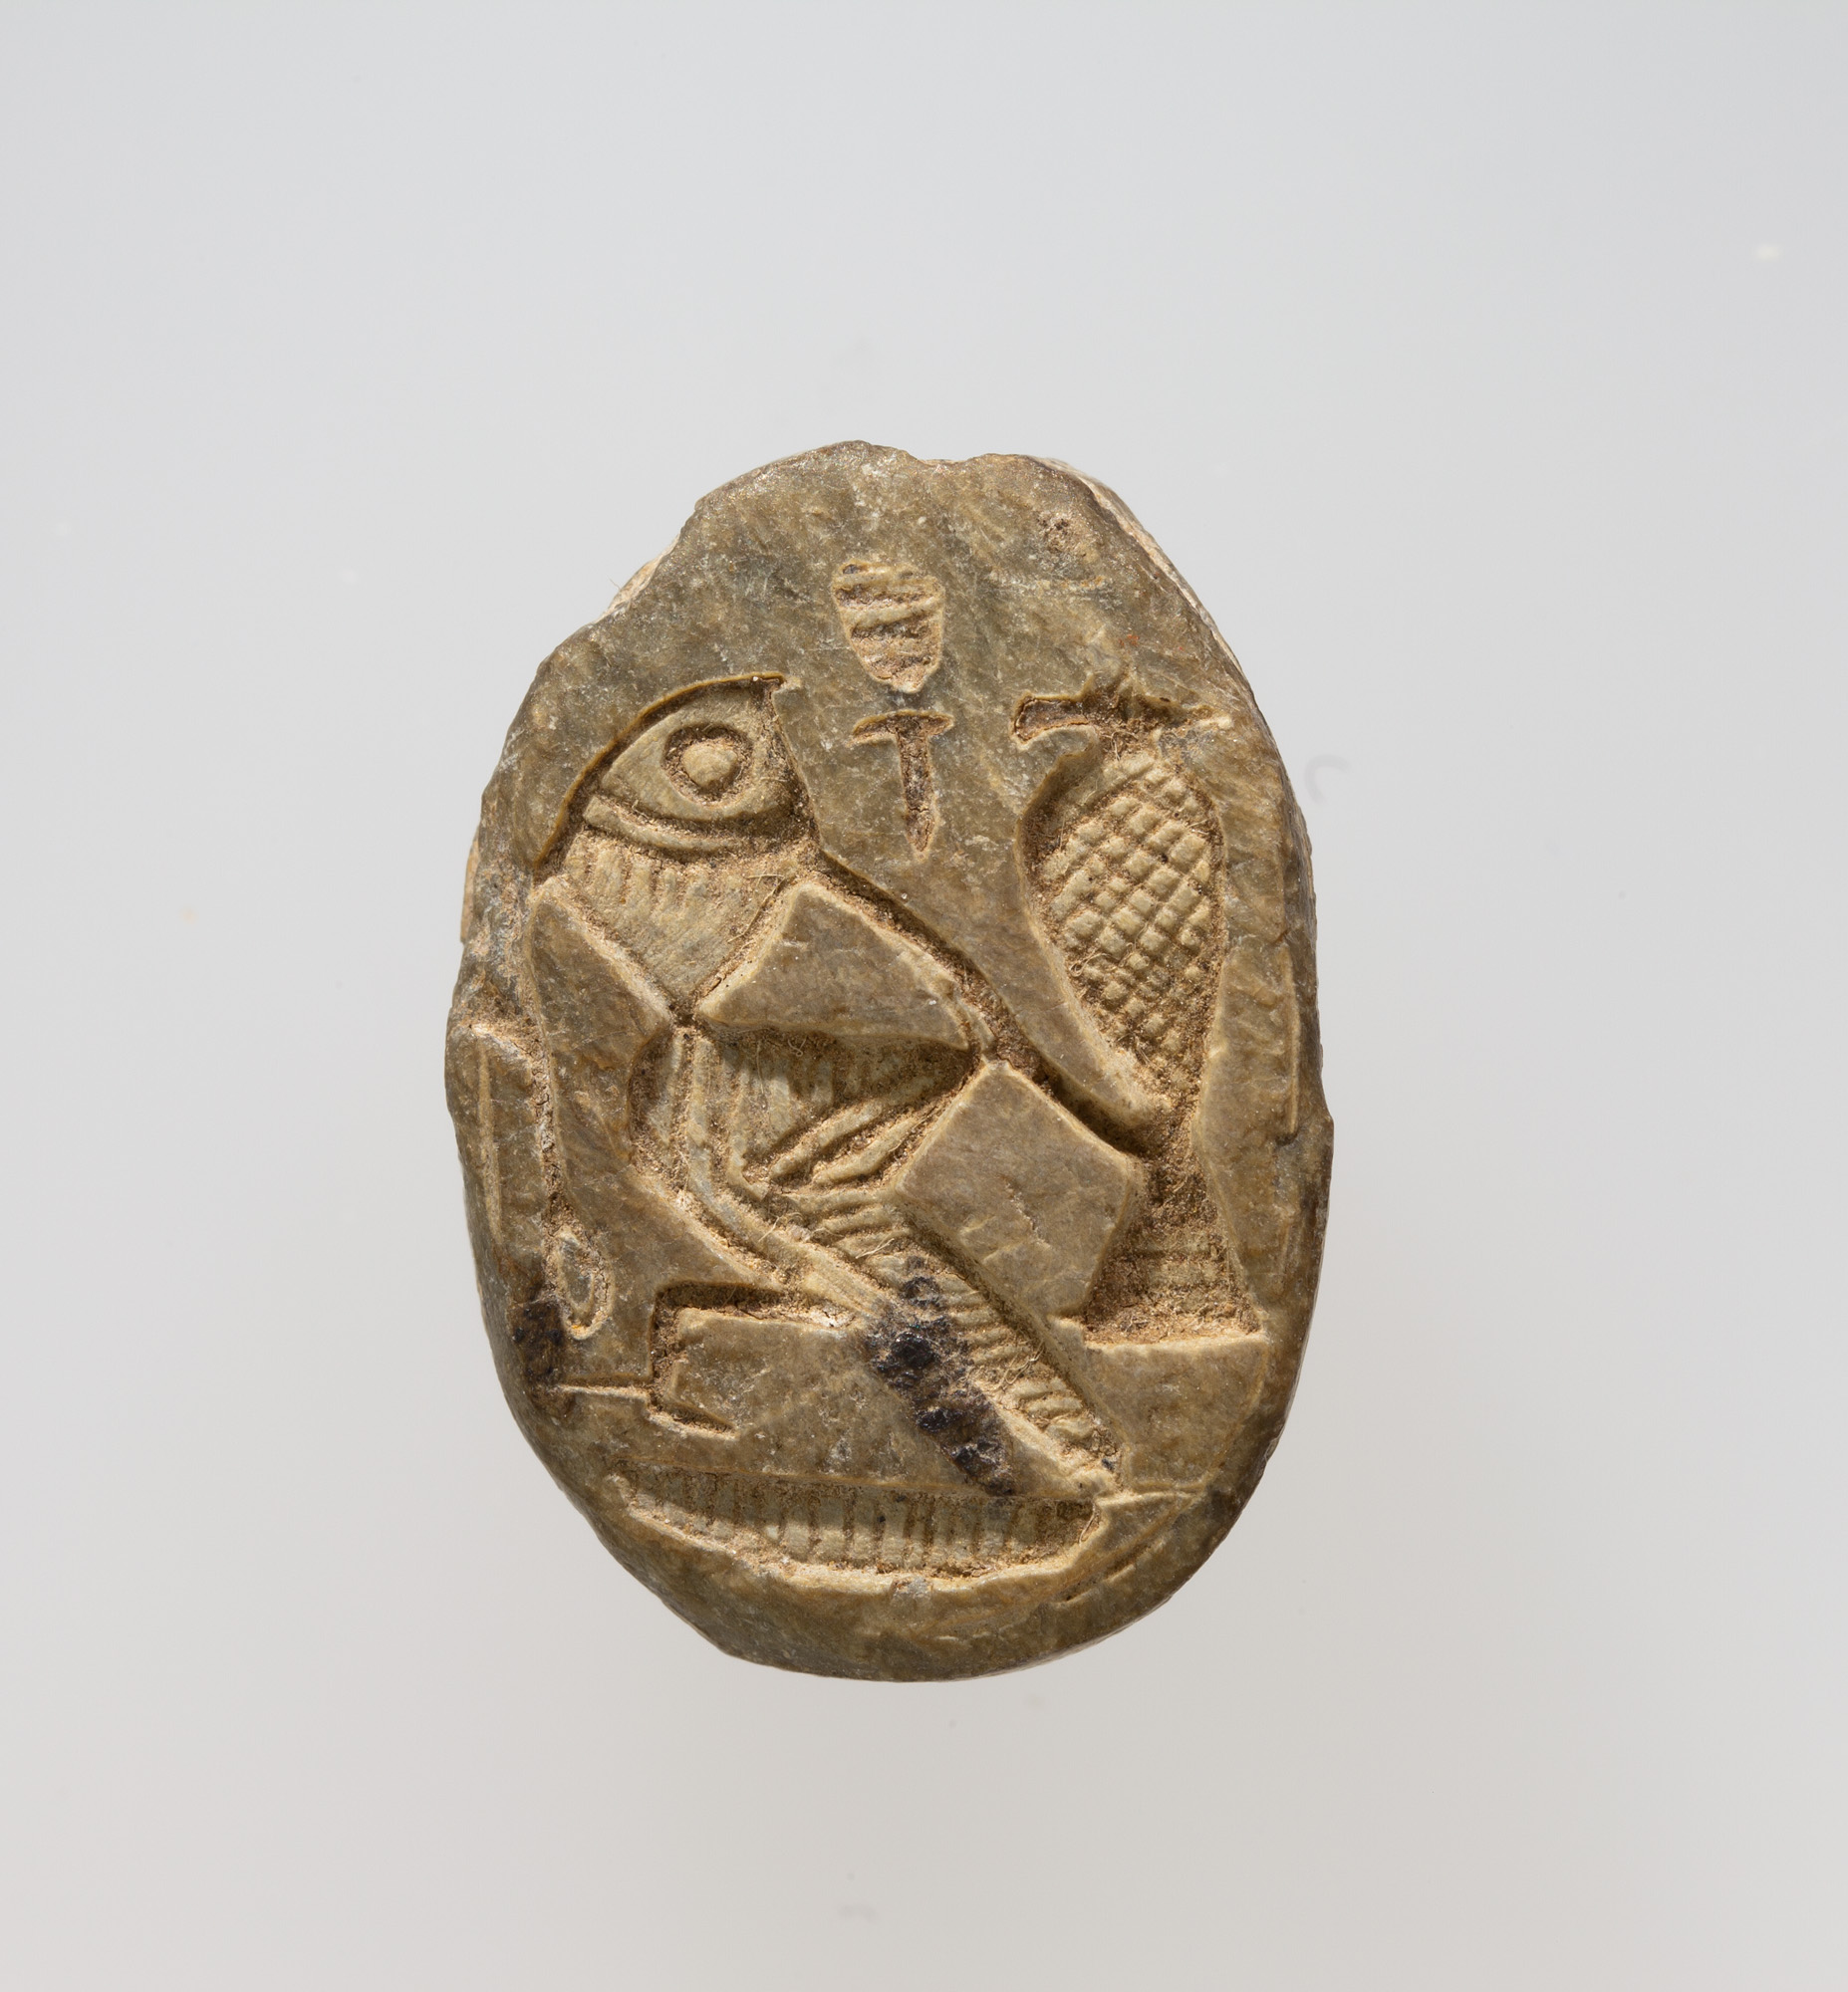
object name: scarab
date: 1479-1458 BCE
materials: faience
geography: egypt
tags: birds,scarabs